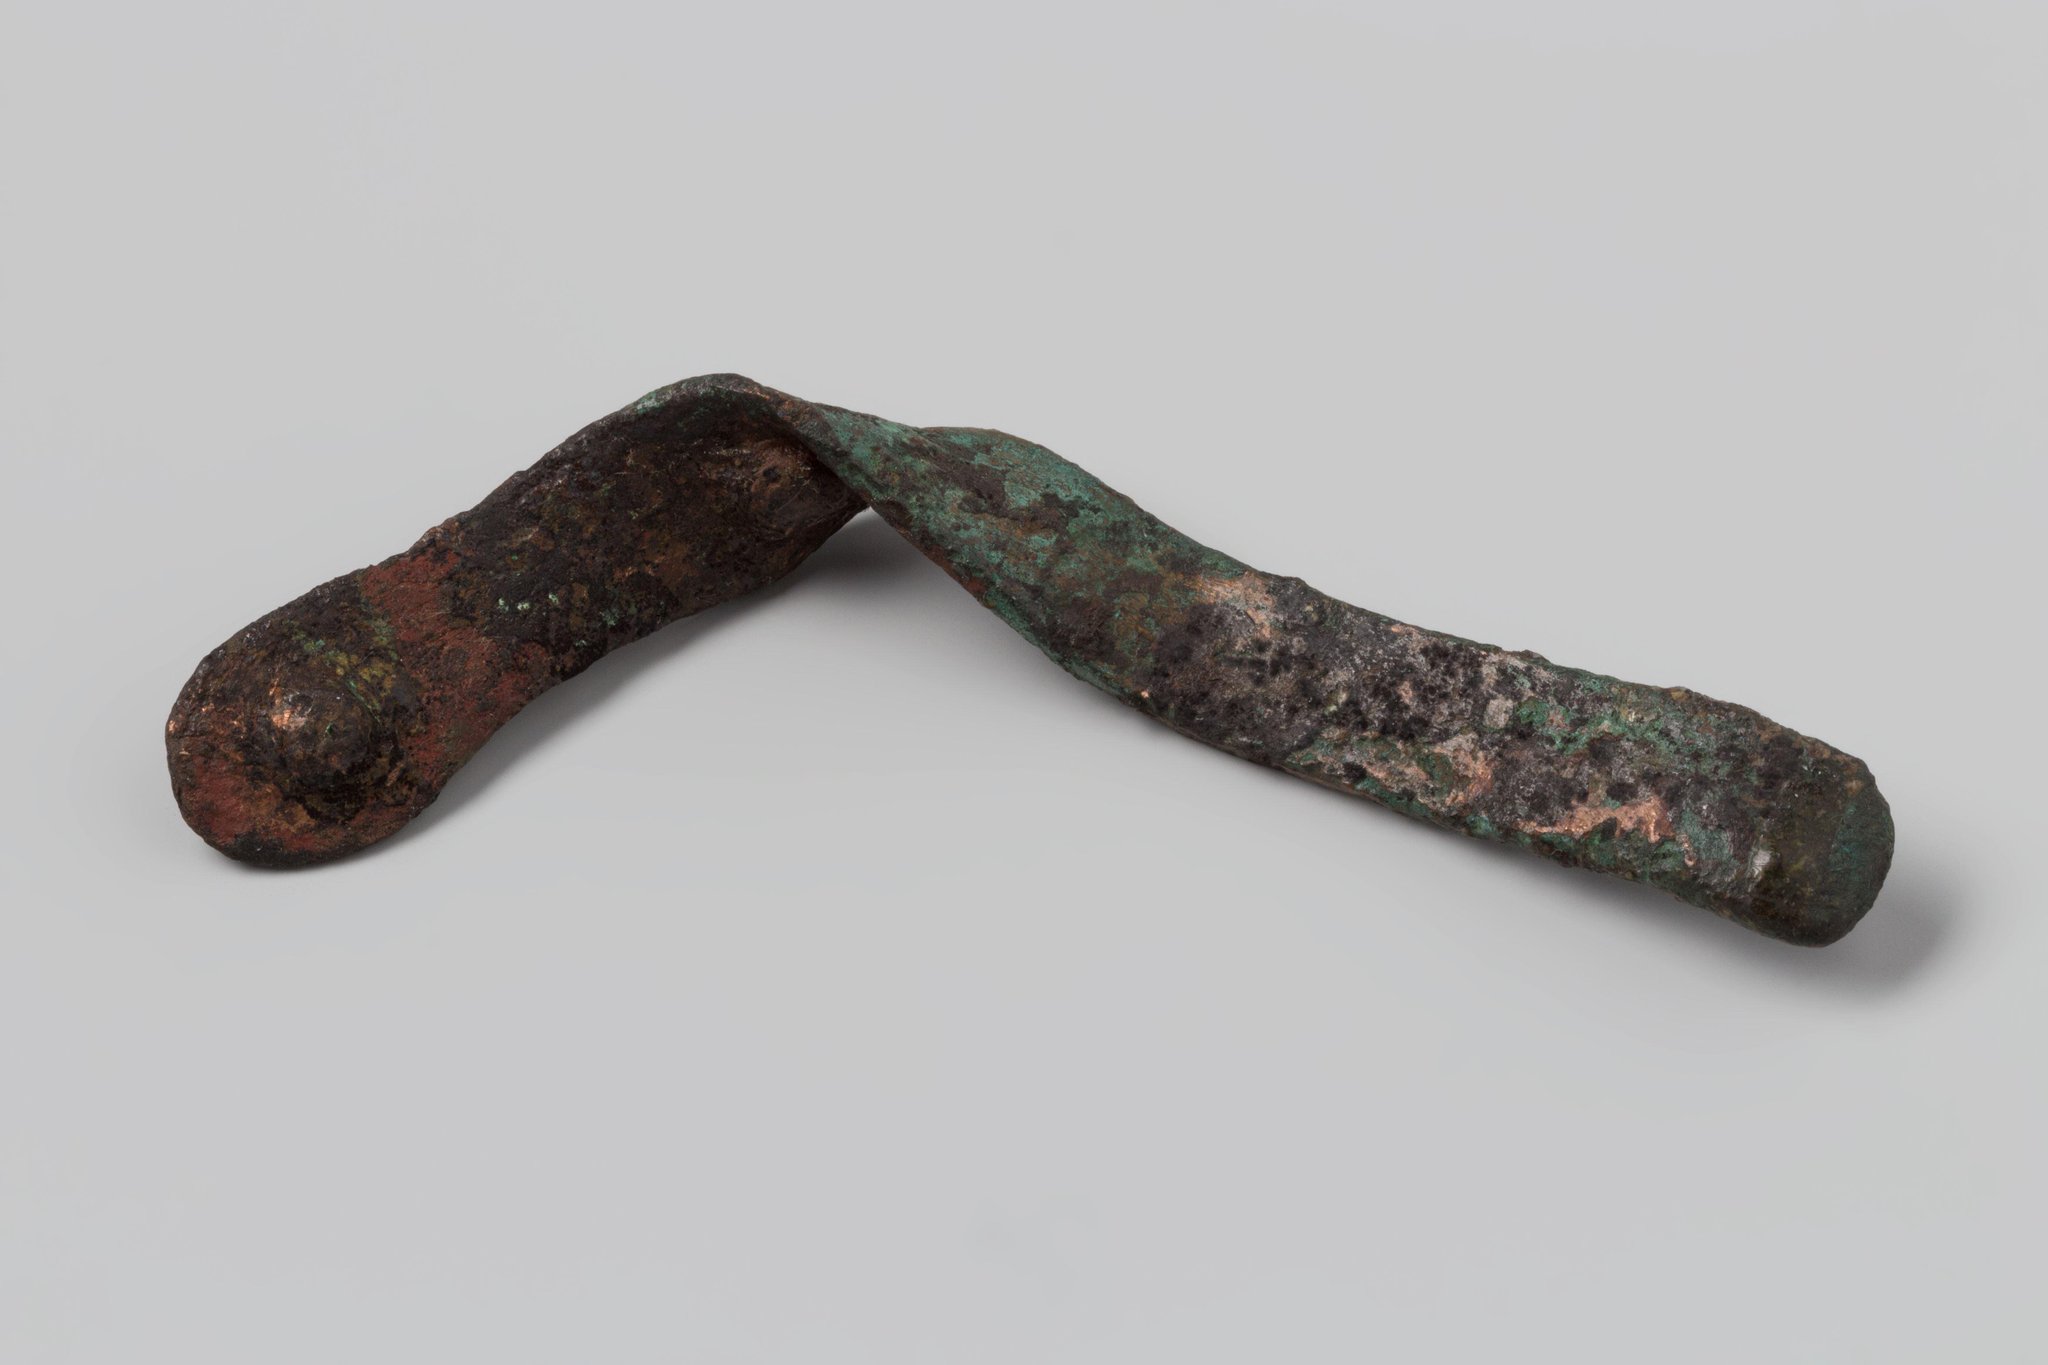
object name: leg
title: Vastgeklonken poot van een verpakking uit het wrak van de Oost-Indiëvaarder Hollandia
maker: Anonymous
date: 1700-1743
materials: copper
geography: netherlands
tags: verenigde oostindische compagnie, hollandia (schip), annet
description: Container, leg, revited; id. NG 1980-27H3056, bent. Leg.